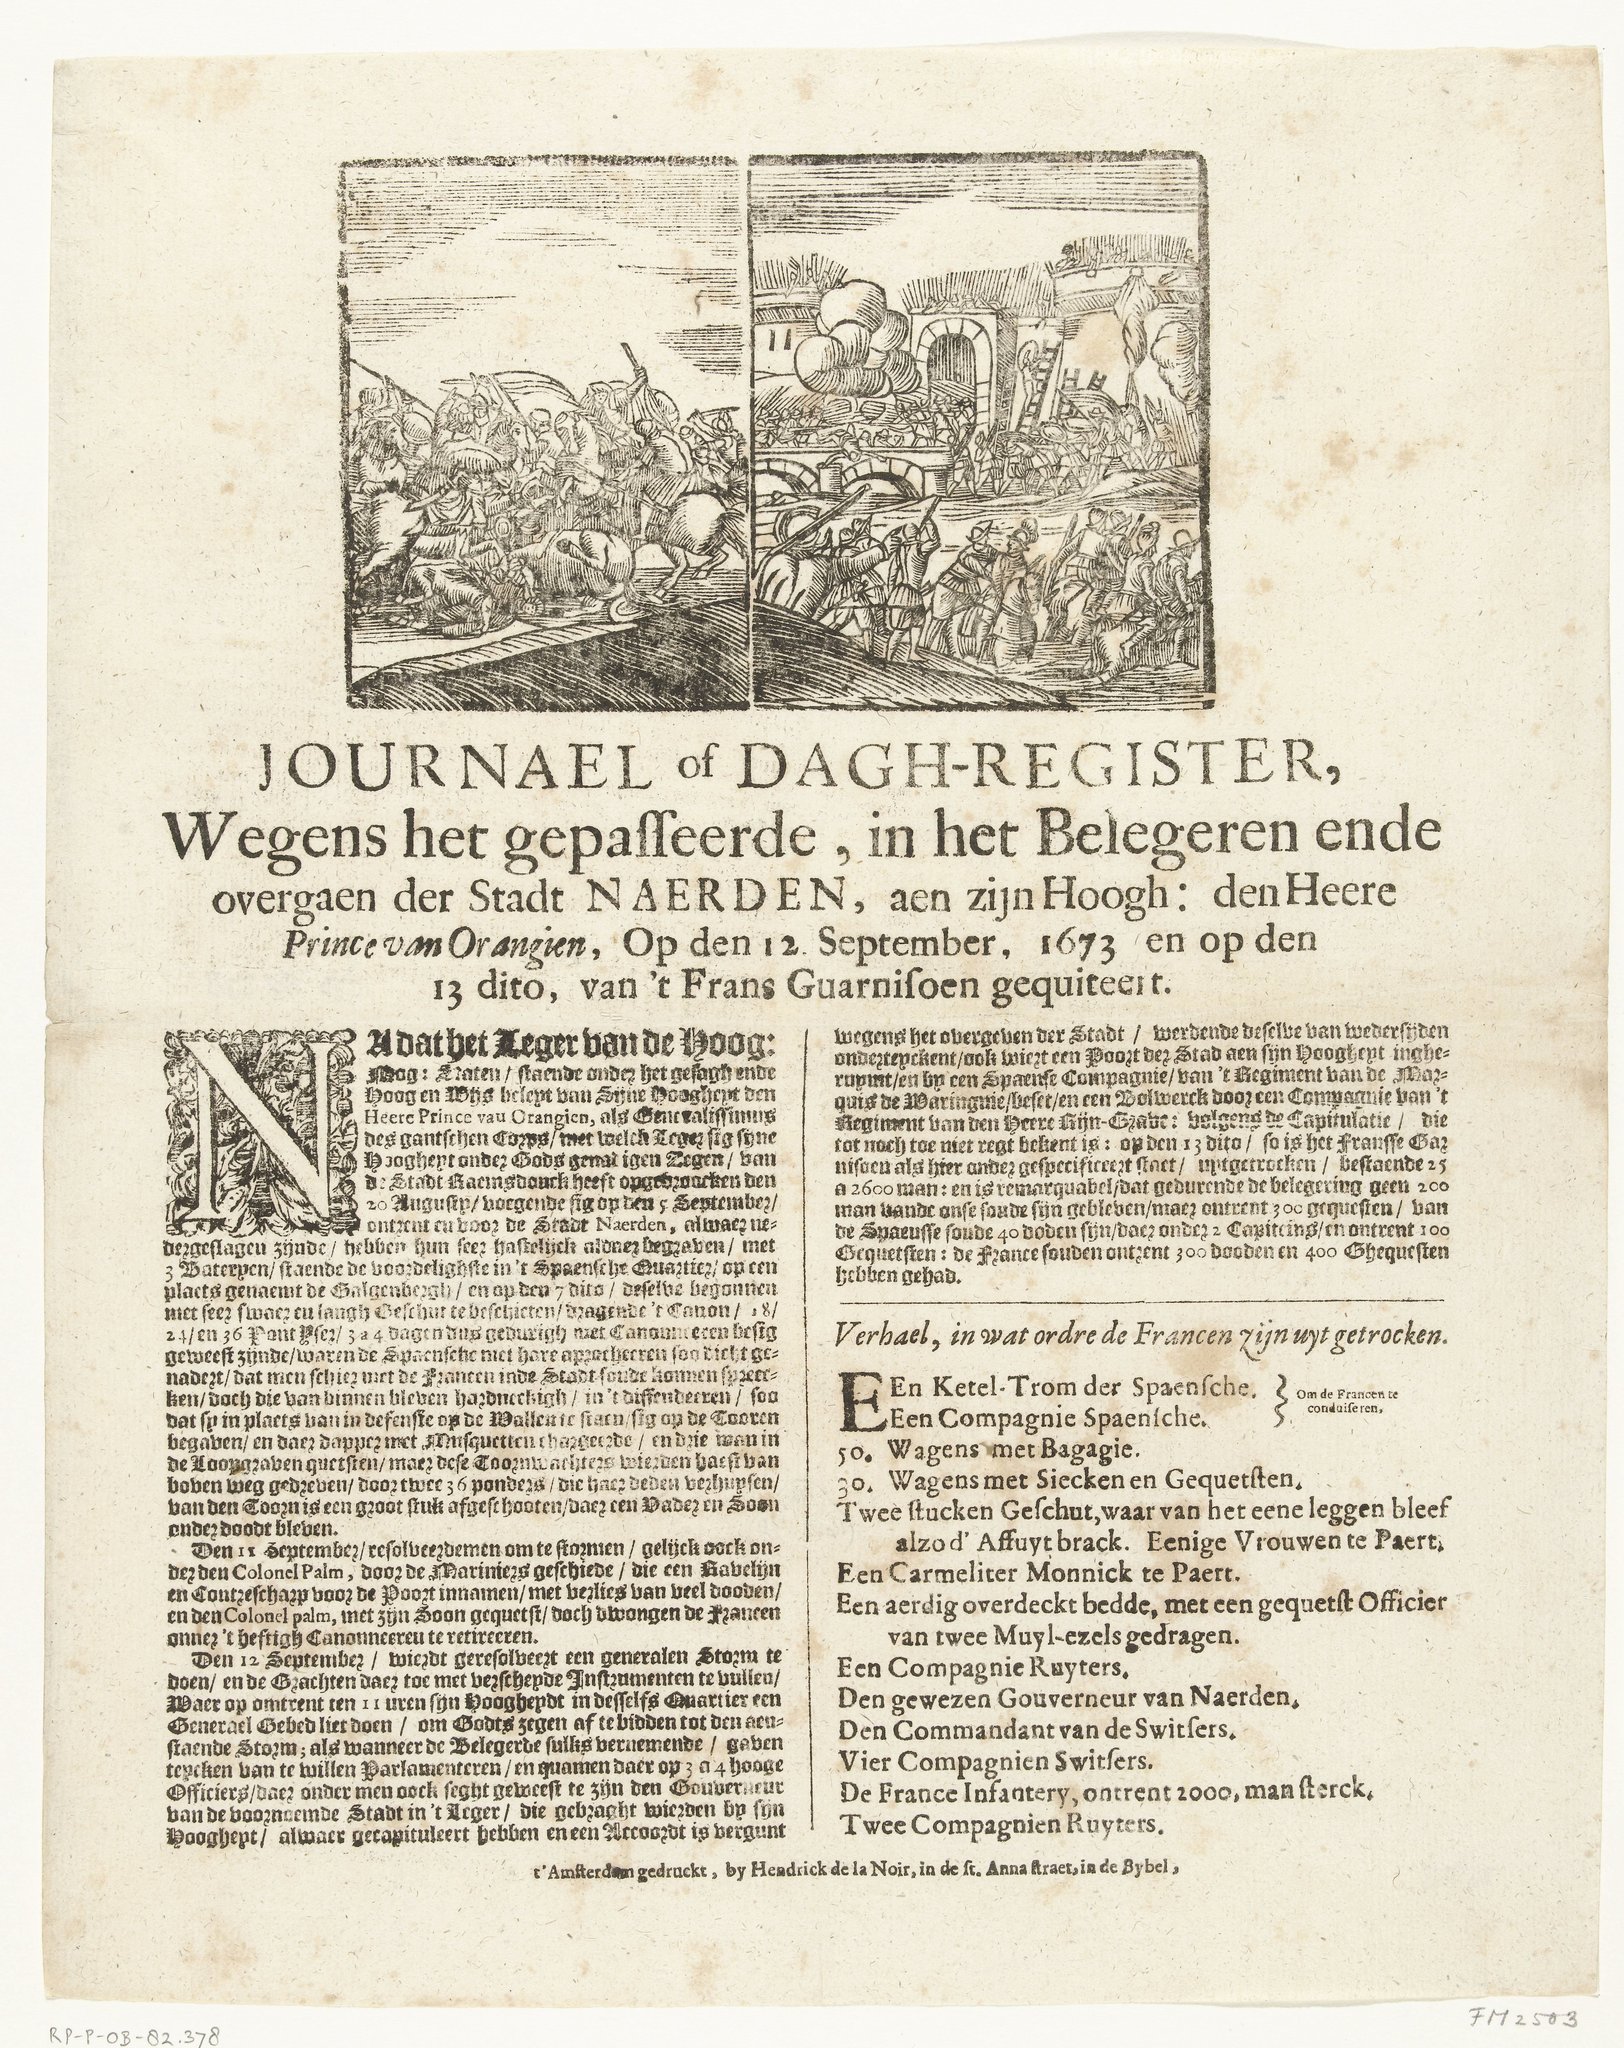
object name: print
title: Journael of Dagh-Register, Wegens het gepasseerde, in het Belegeren ende overgaen der Stadt Naerden, aen zijn Hoogh: den Heere Prince van Orangien, Op den 12 September, 1673 en op den 13 dito, van 't Frans Guarnisoen gequiteert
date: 1673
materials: paper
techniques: letterpress printing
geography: northern netherlands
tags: william iii (prince of orange and king of england, scotland, and ireland), siege, position war, battle (+ land forces)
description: De verovering van Naarden door de prins Willem III op 12 september 1673 en het vertrek van het Franse garnizoen op 13 september 1673. Blad met twee oudere houtsneden van een ruitergevecht en de bestorming van een stad. Hieronder twee kolommen tekst met een beschrijving van de gebeurtenissen en de volgorde waarin de Fransen de stad verlaten hebben.